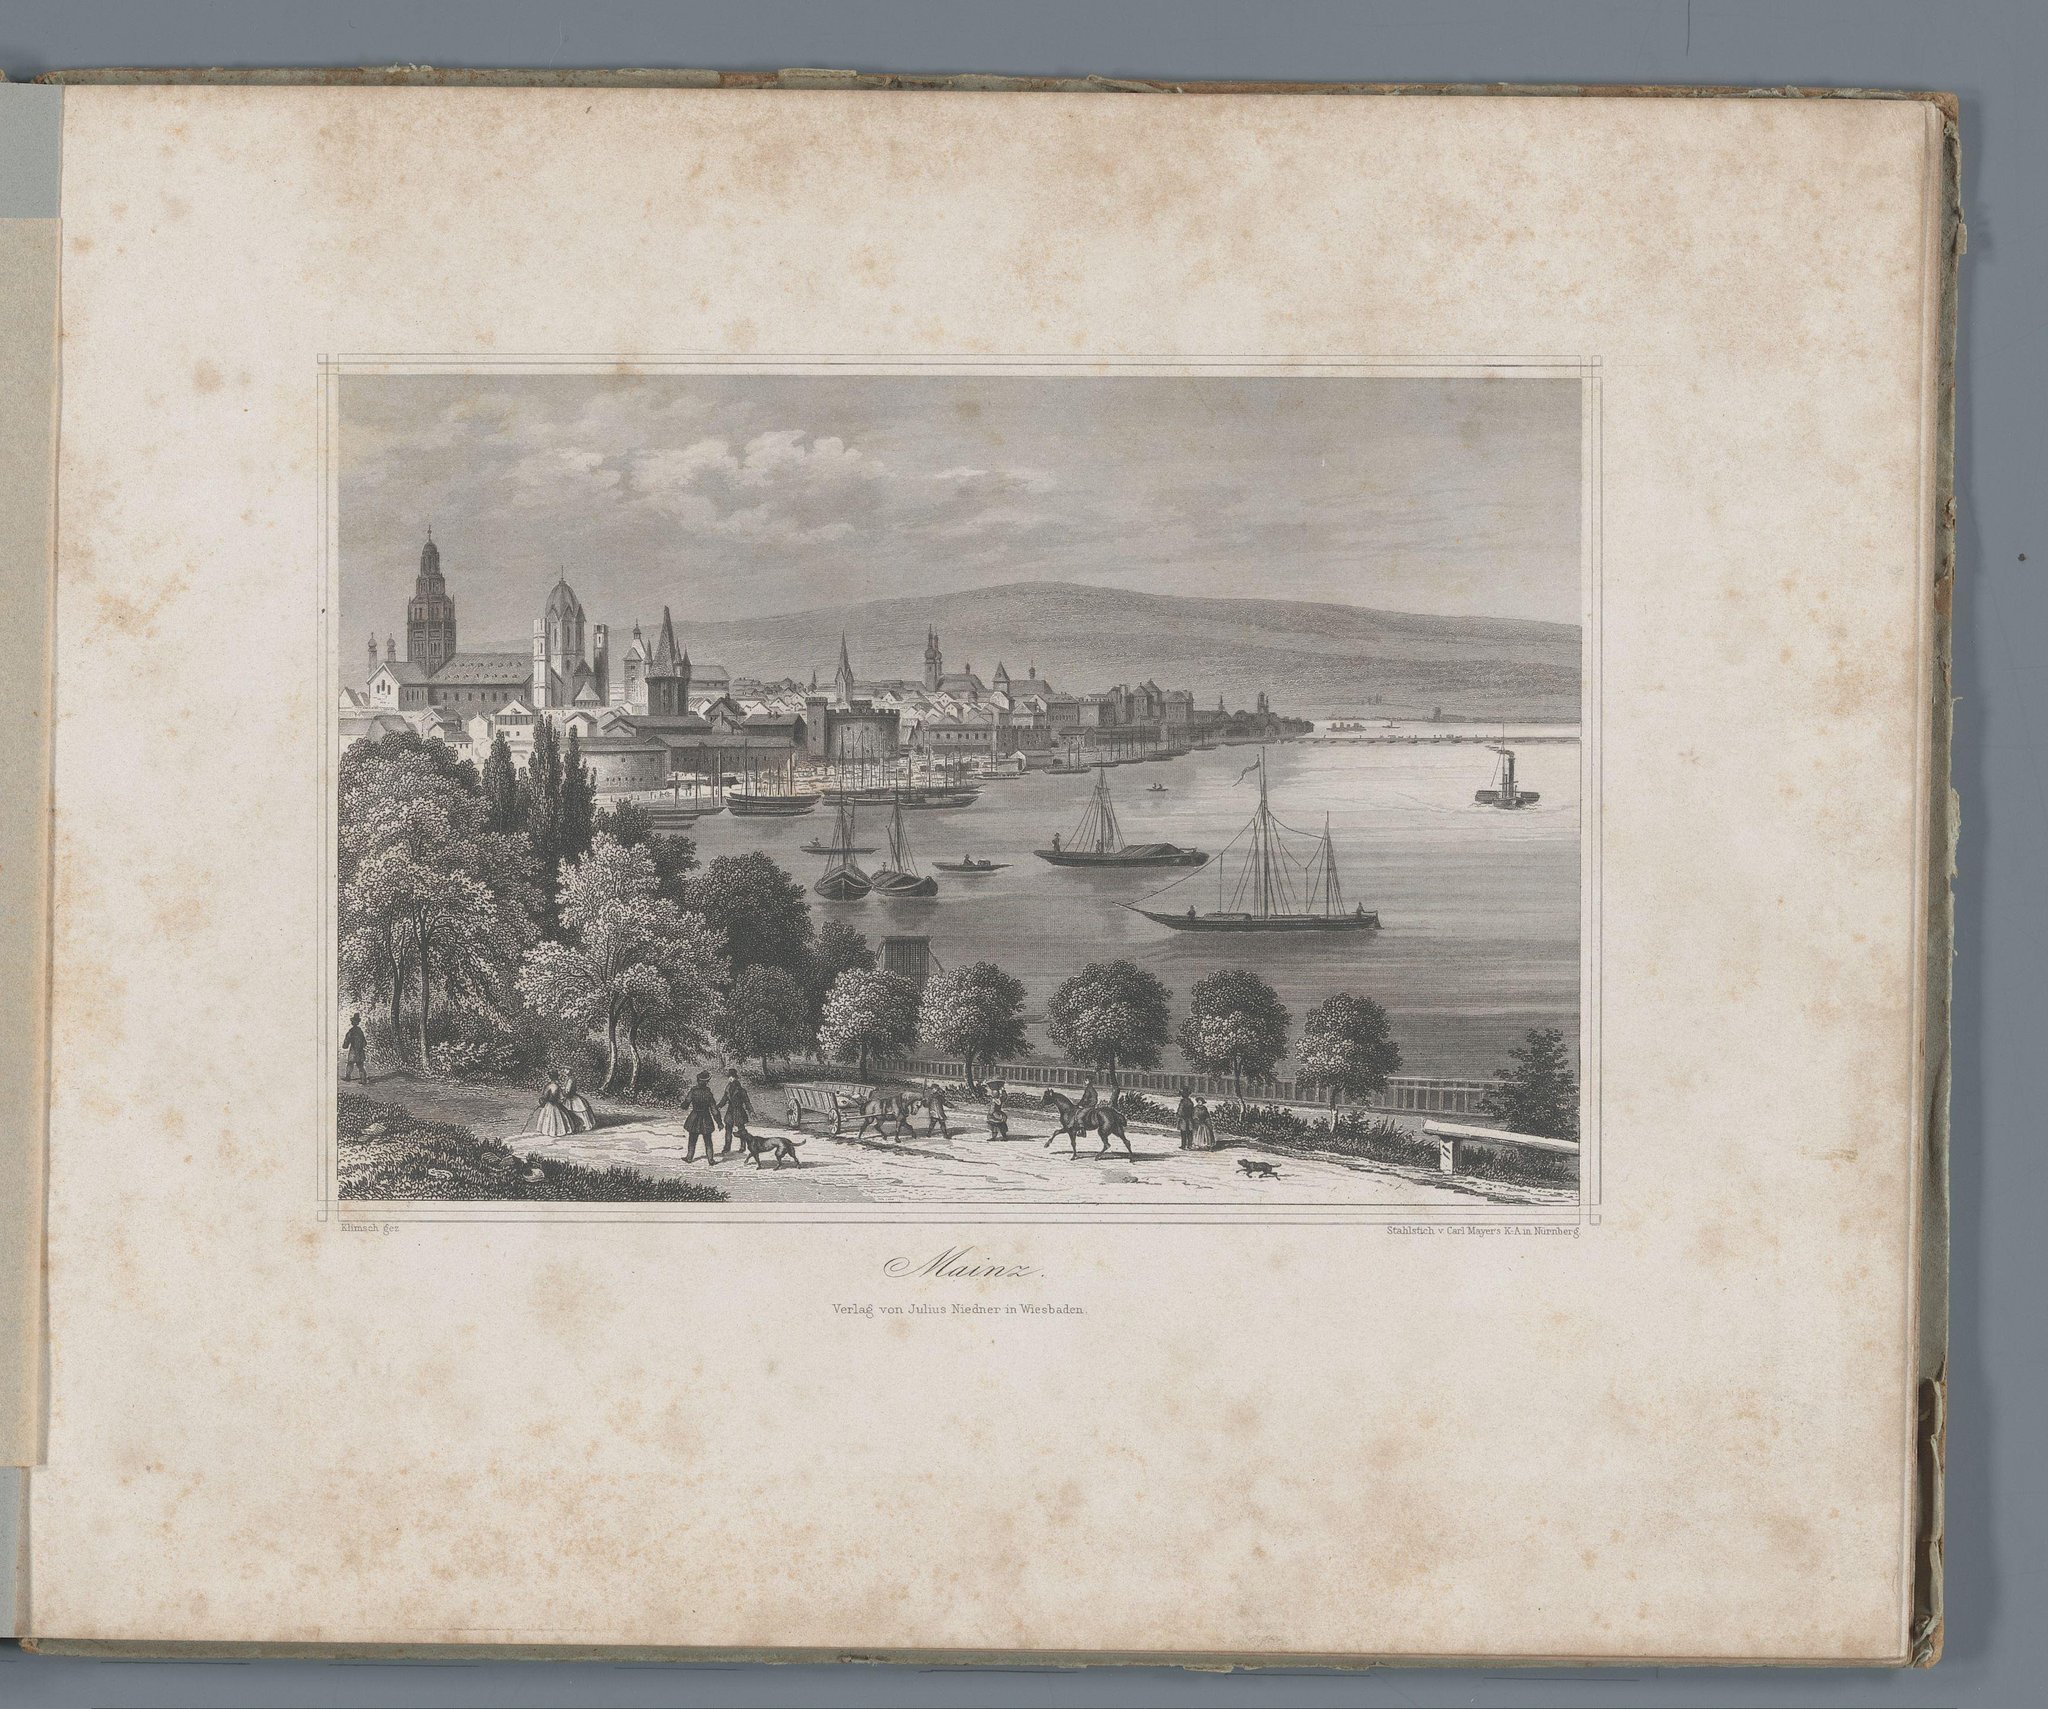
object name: print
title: Zwölf der schönsten Ansichten des Rheins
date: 1822-1868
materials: paper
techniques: engraving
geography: nuremberg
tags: river, prospect of city, town panorama, silhouette of city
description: Deze prent maakt deel uit van een album met twaalf prenten.